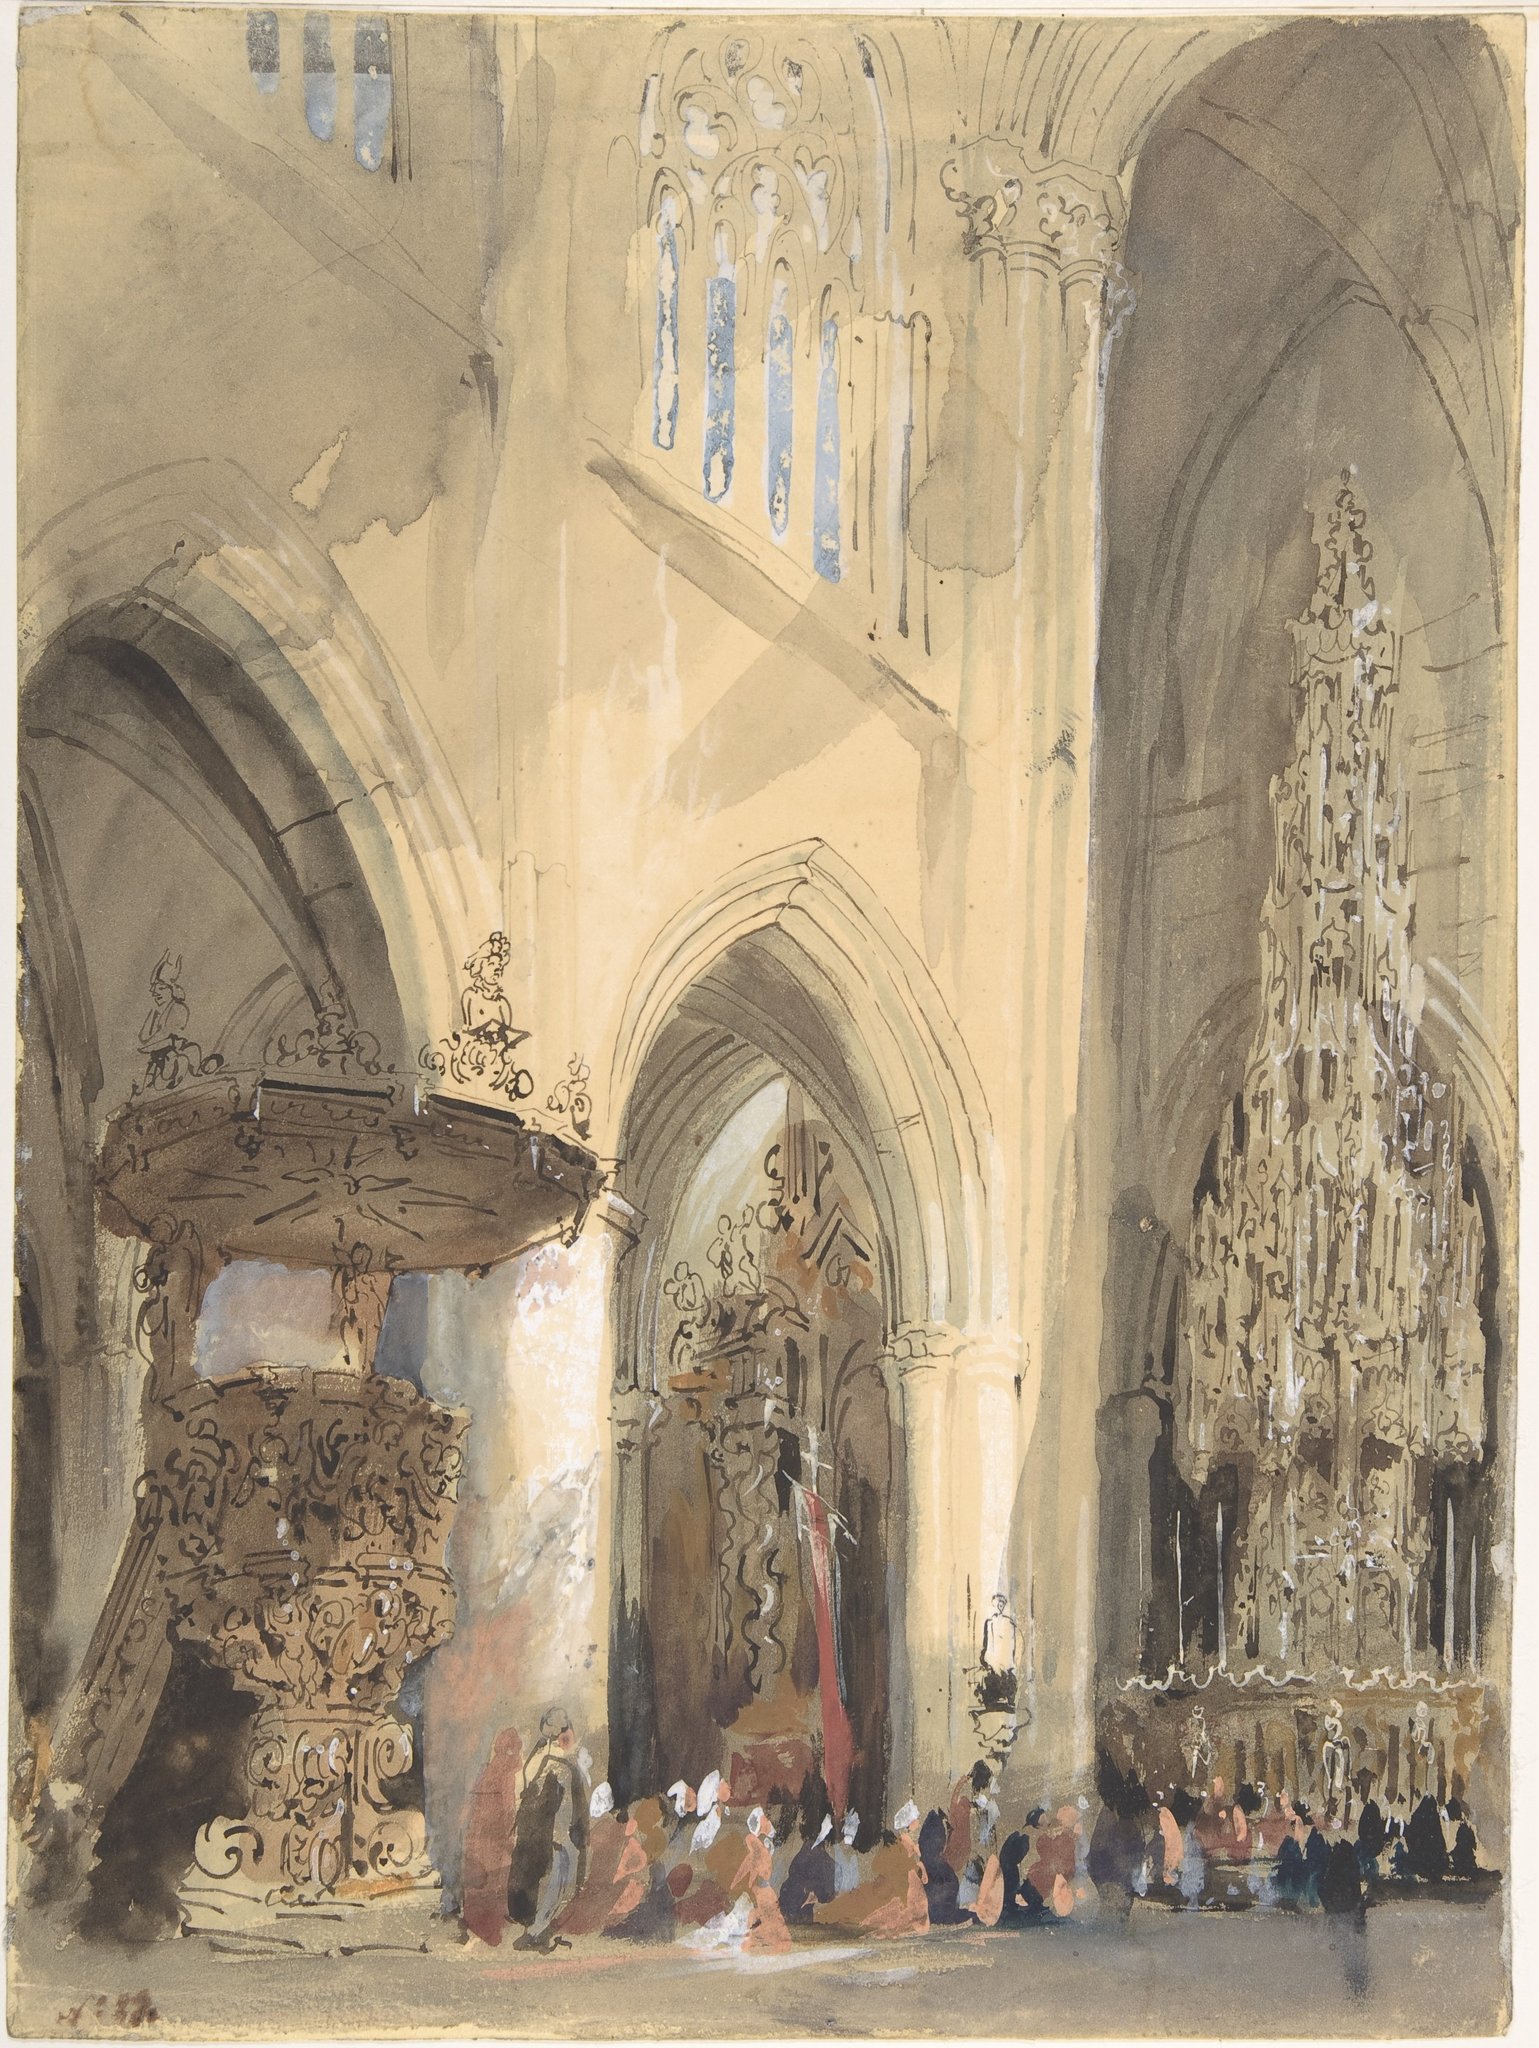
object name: drawing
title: Interior of the Church of St. Jacques, Louvain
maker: genaro (jenaro) pérez villaamil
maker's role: artist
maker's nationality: spanish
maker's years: 1807-1854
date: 1807-1854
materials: gouache, ink, paper, watercolor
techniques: brush, highlighting, pen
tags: interiors,churches,crowd